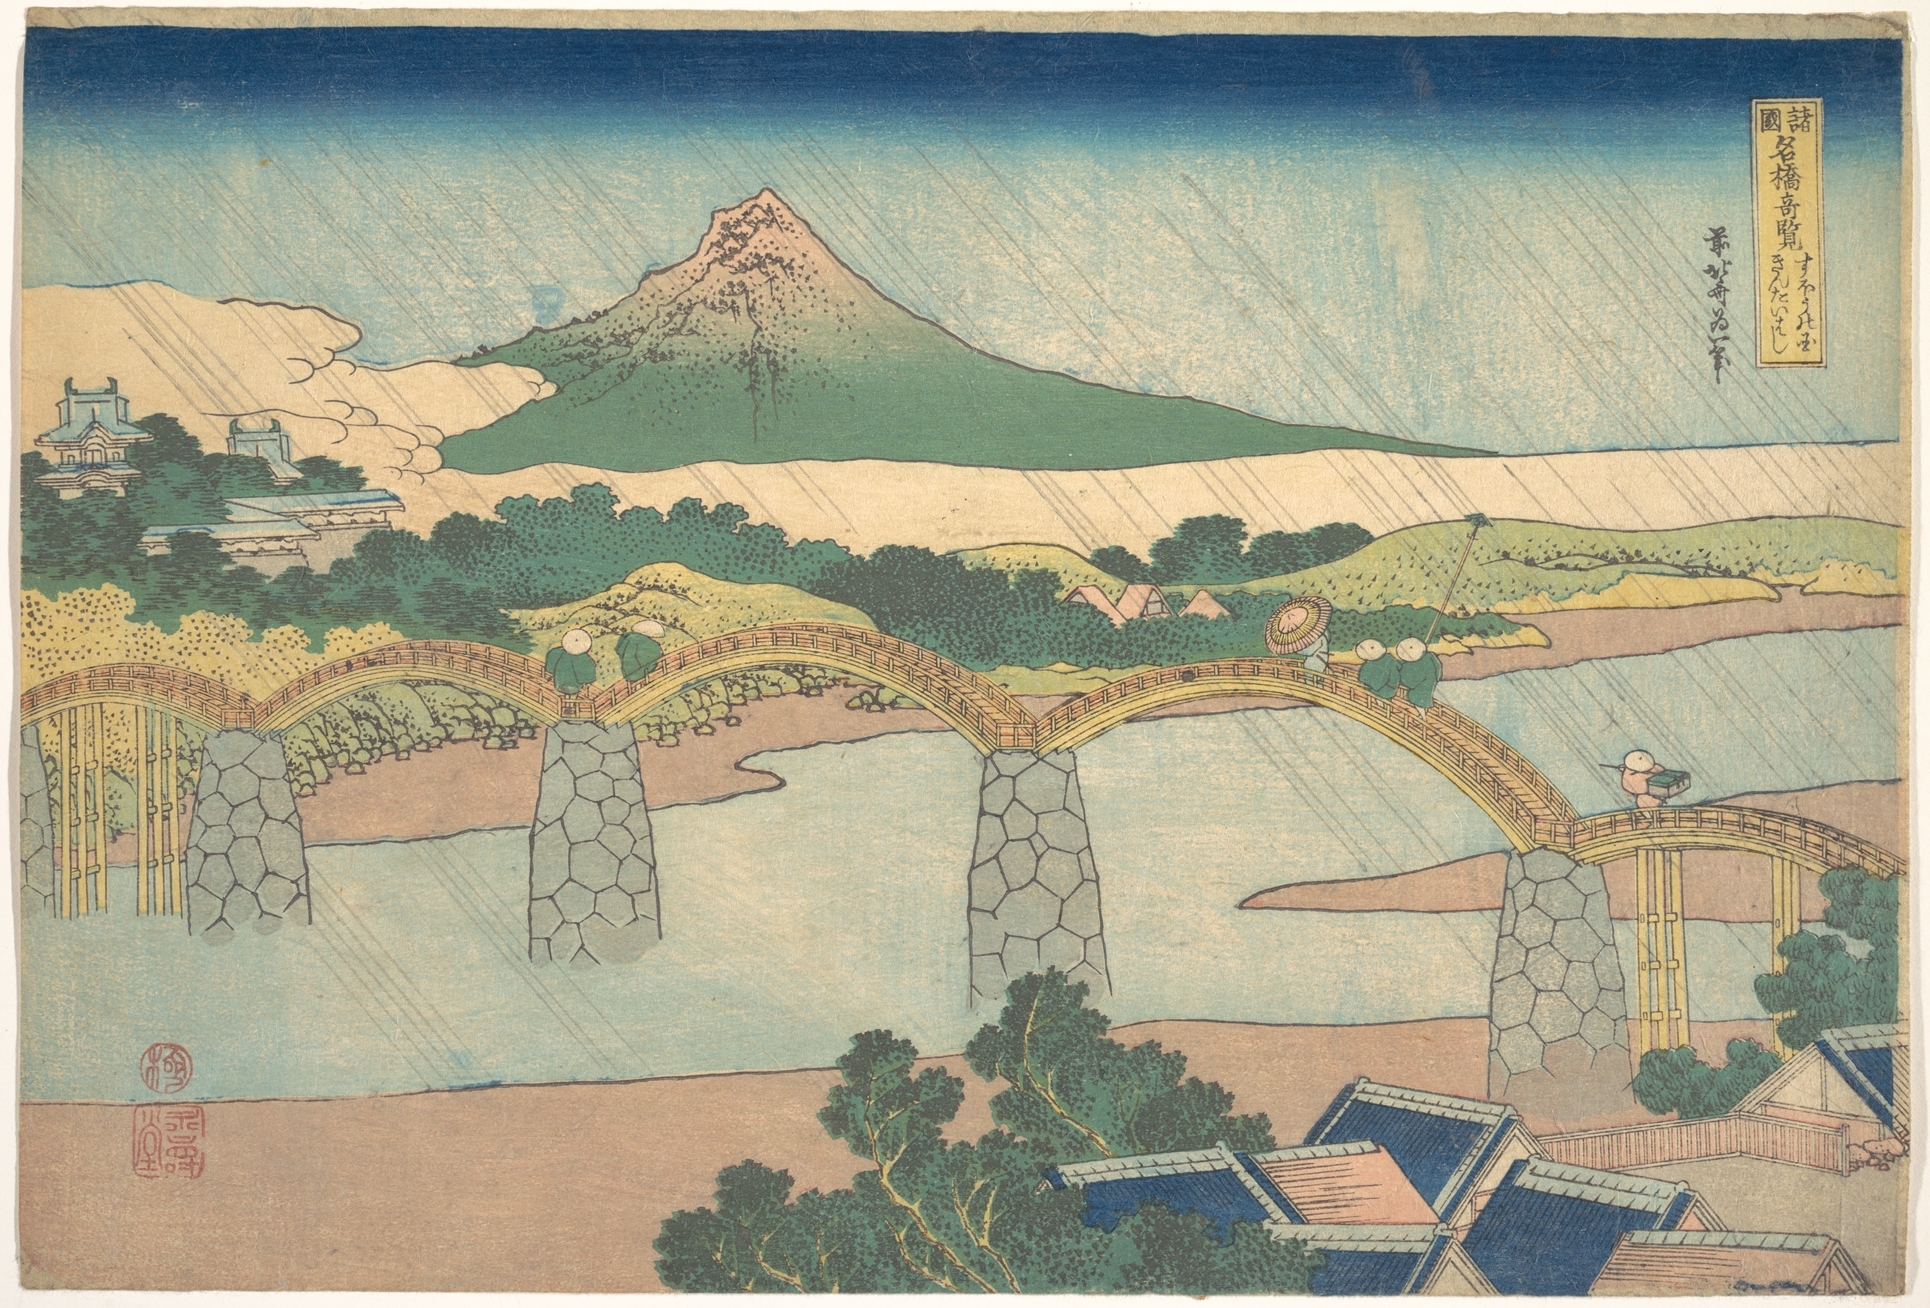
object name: woodblock print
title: Kintai Bridge in Suō Province (Suō no kuni Kintaibashi), from the series Remarkable Views of Bridges in Various Provinces (Shokoku meikyō kiran)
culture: japanese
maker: katsushika hokusai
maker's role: artist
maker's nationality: japanese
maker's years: 1760-1849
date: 1830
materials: ink, paper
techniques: woodblock print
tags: bridges,rivers,mountains